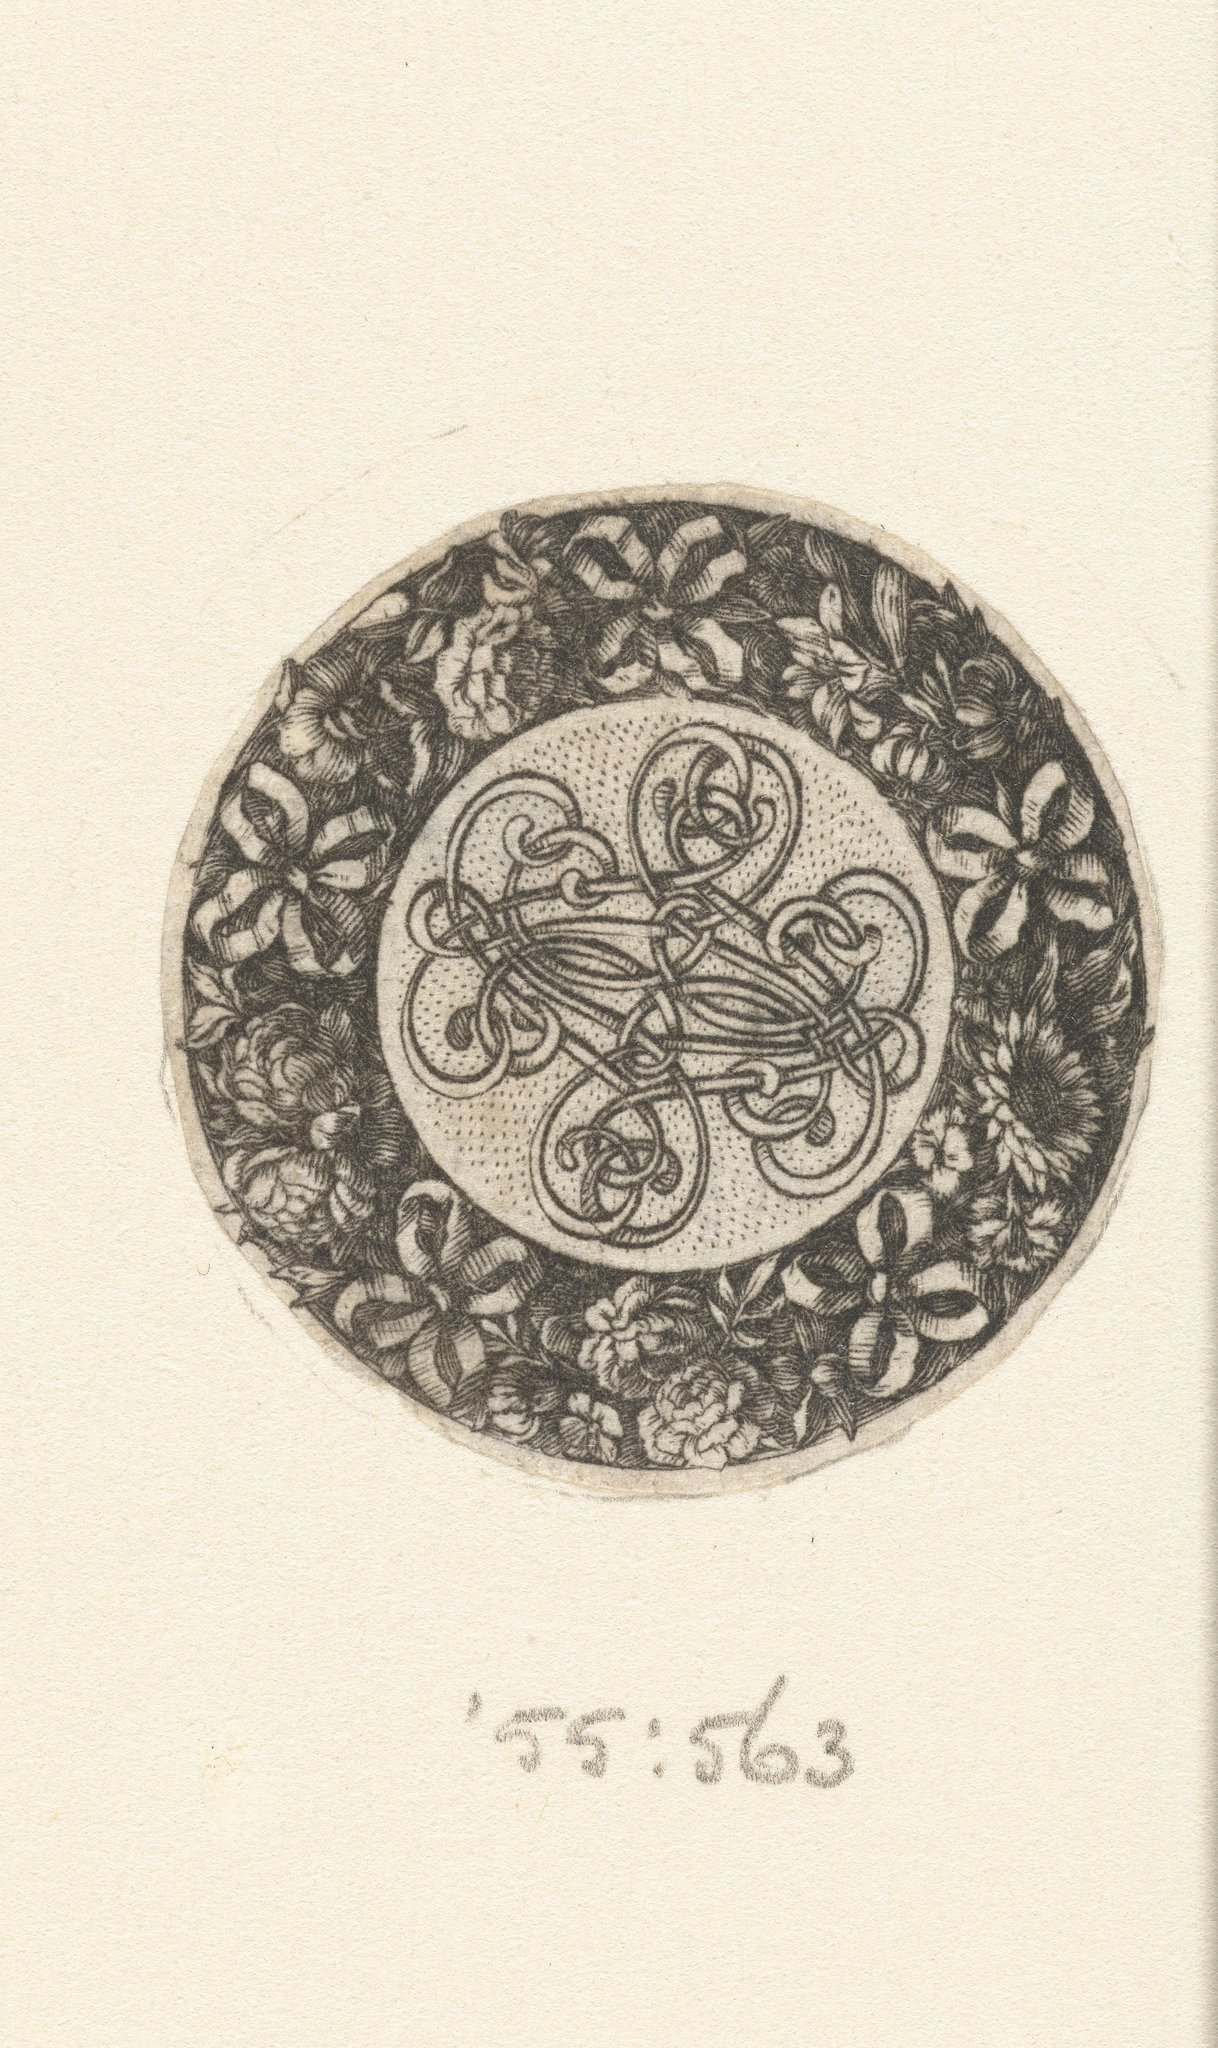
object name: print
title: Medaillon met vlechtwerk en bloemen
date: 1631-1686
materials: paper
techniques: engraving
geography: france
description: Medaillon van blad 5 uit de serie Liures De Fleurs propres pour O'rfeures Et Graueurs.